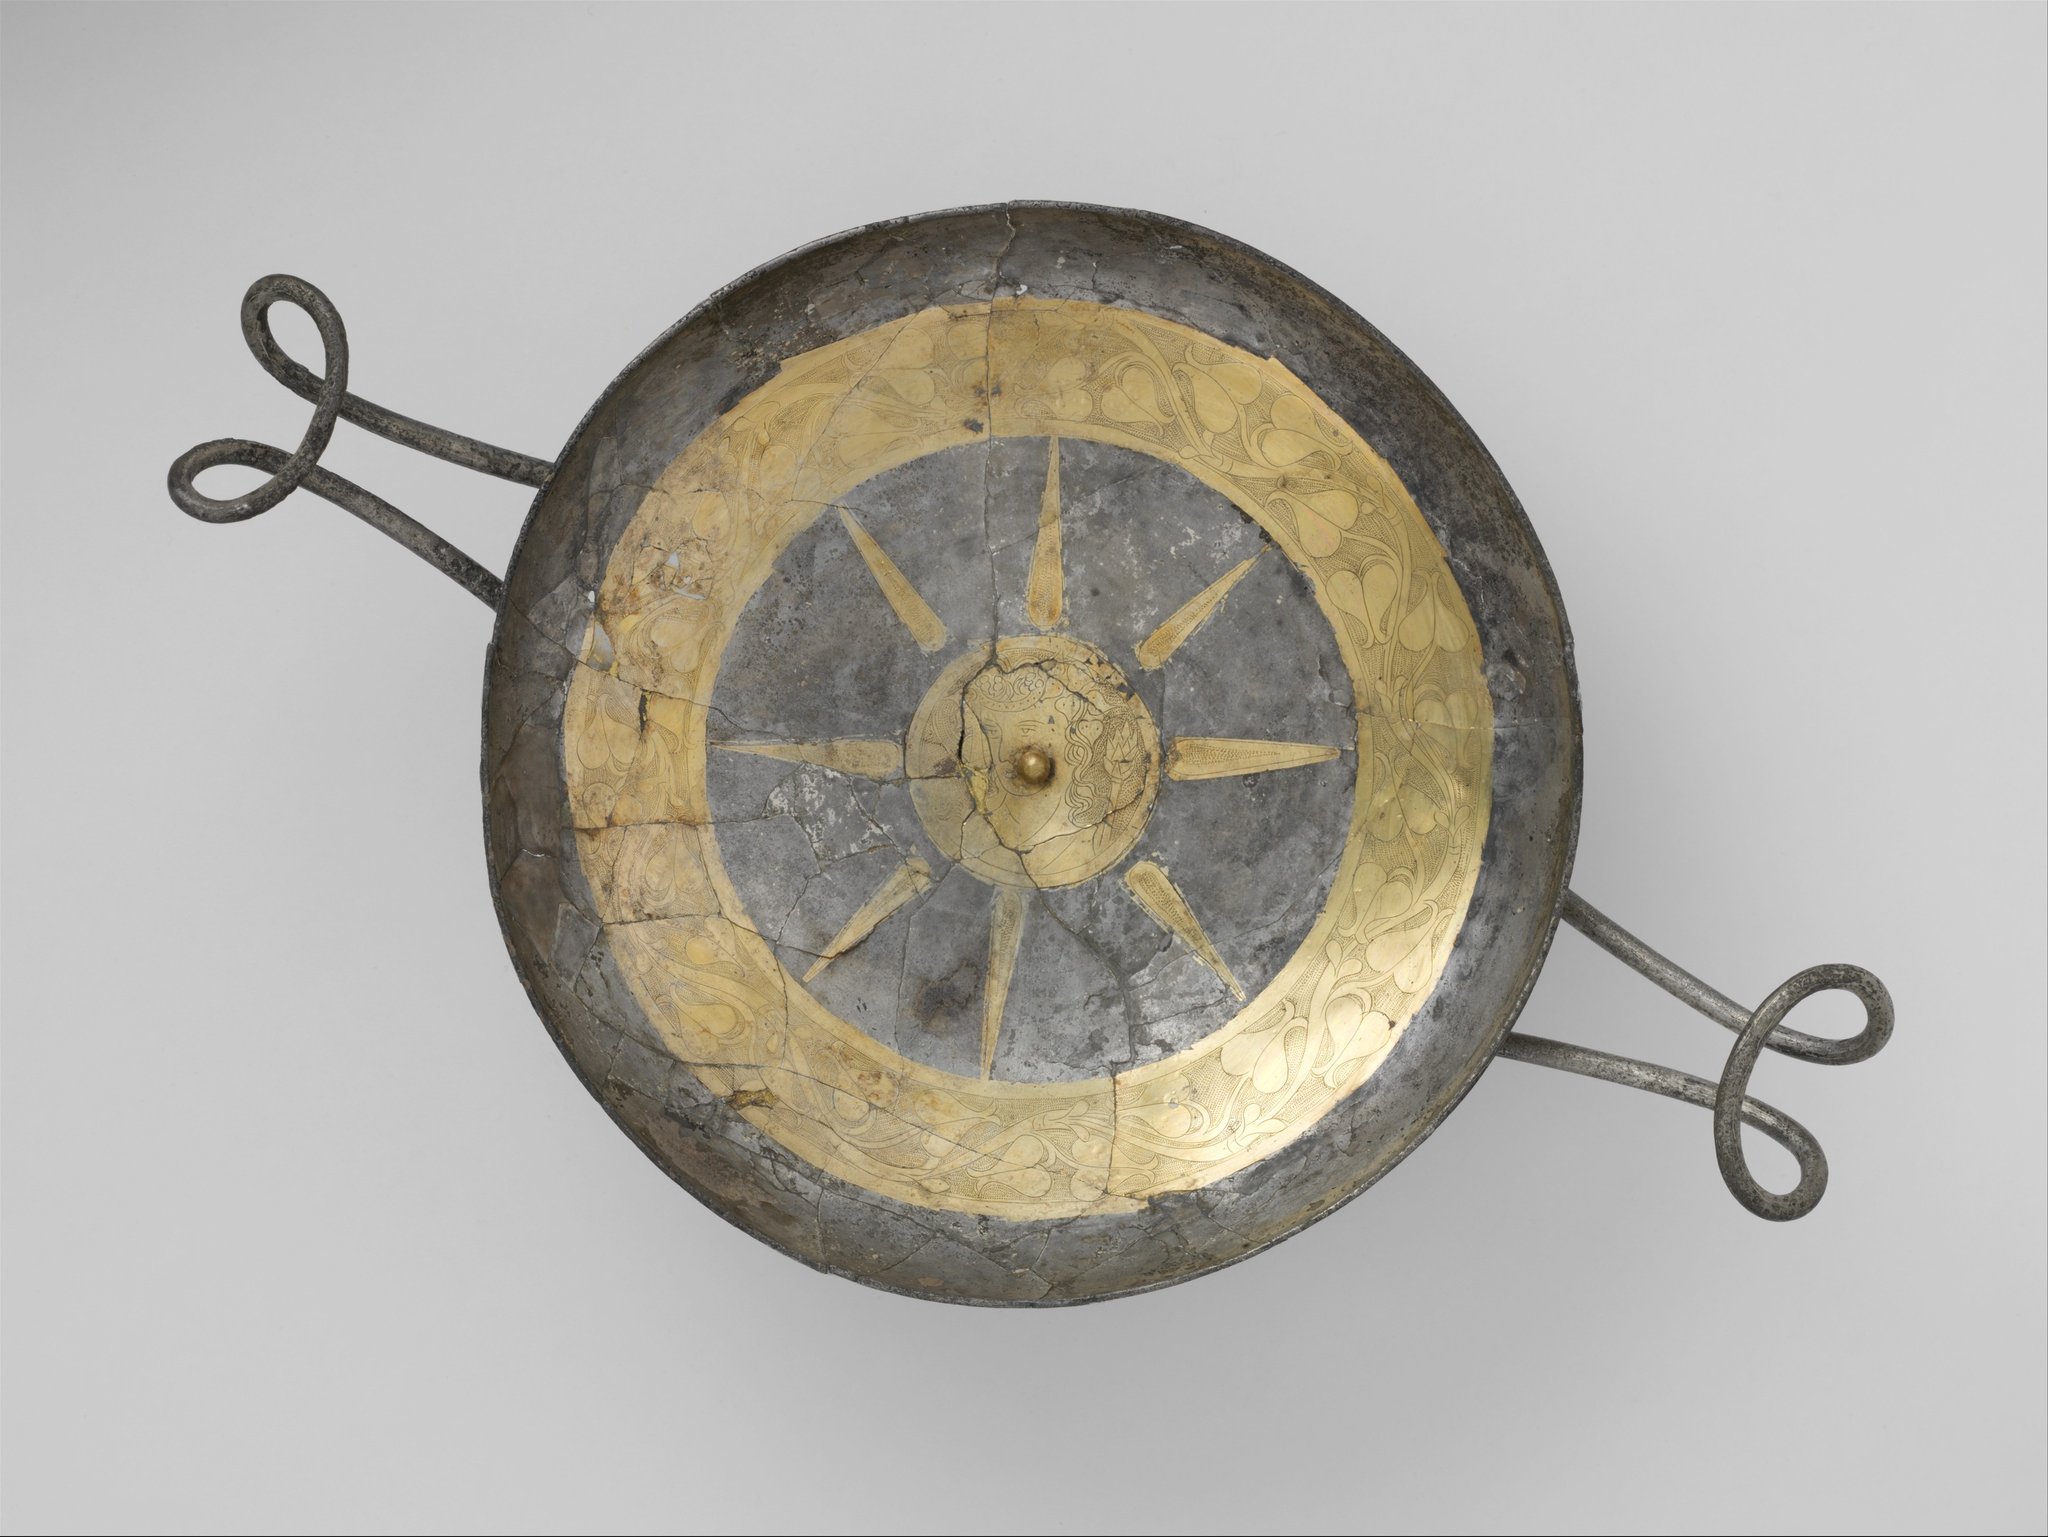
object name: cup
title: Silver-gilt cup (one of a pair)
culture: greek or south italian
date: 400-201 BCE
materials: gold, silver